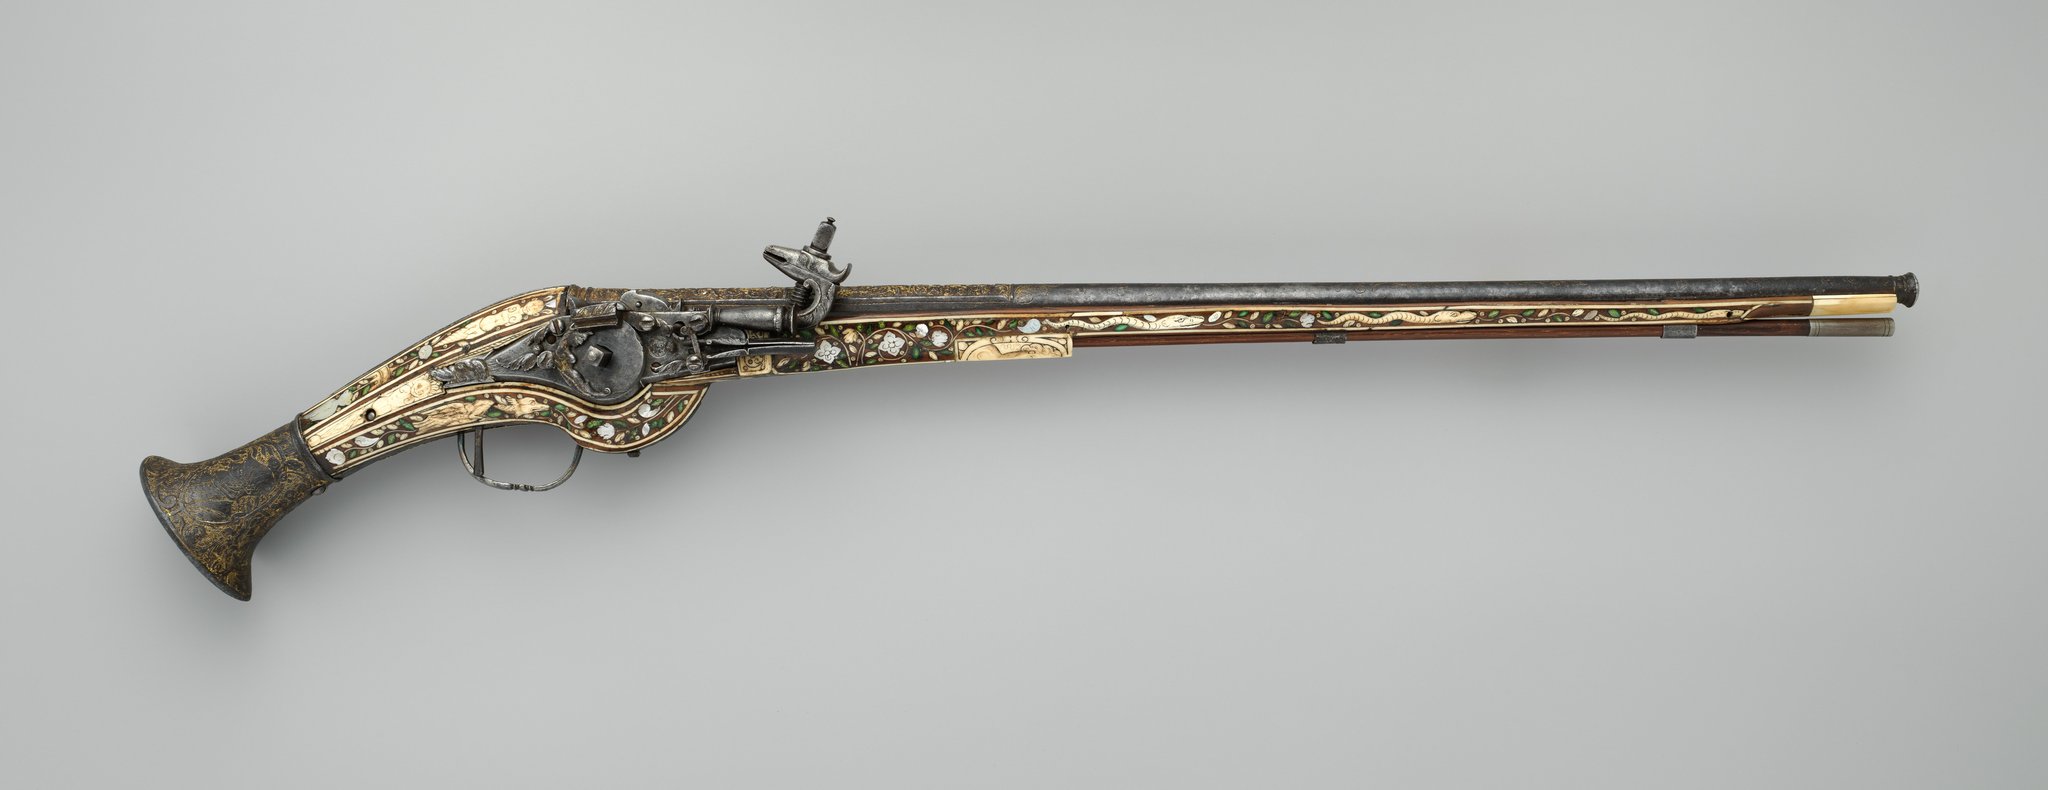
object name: wheellock pistol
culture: french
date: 1580-1600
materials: gold, mother of pearl, steel, wood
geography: france